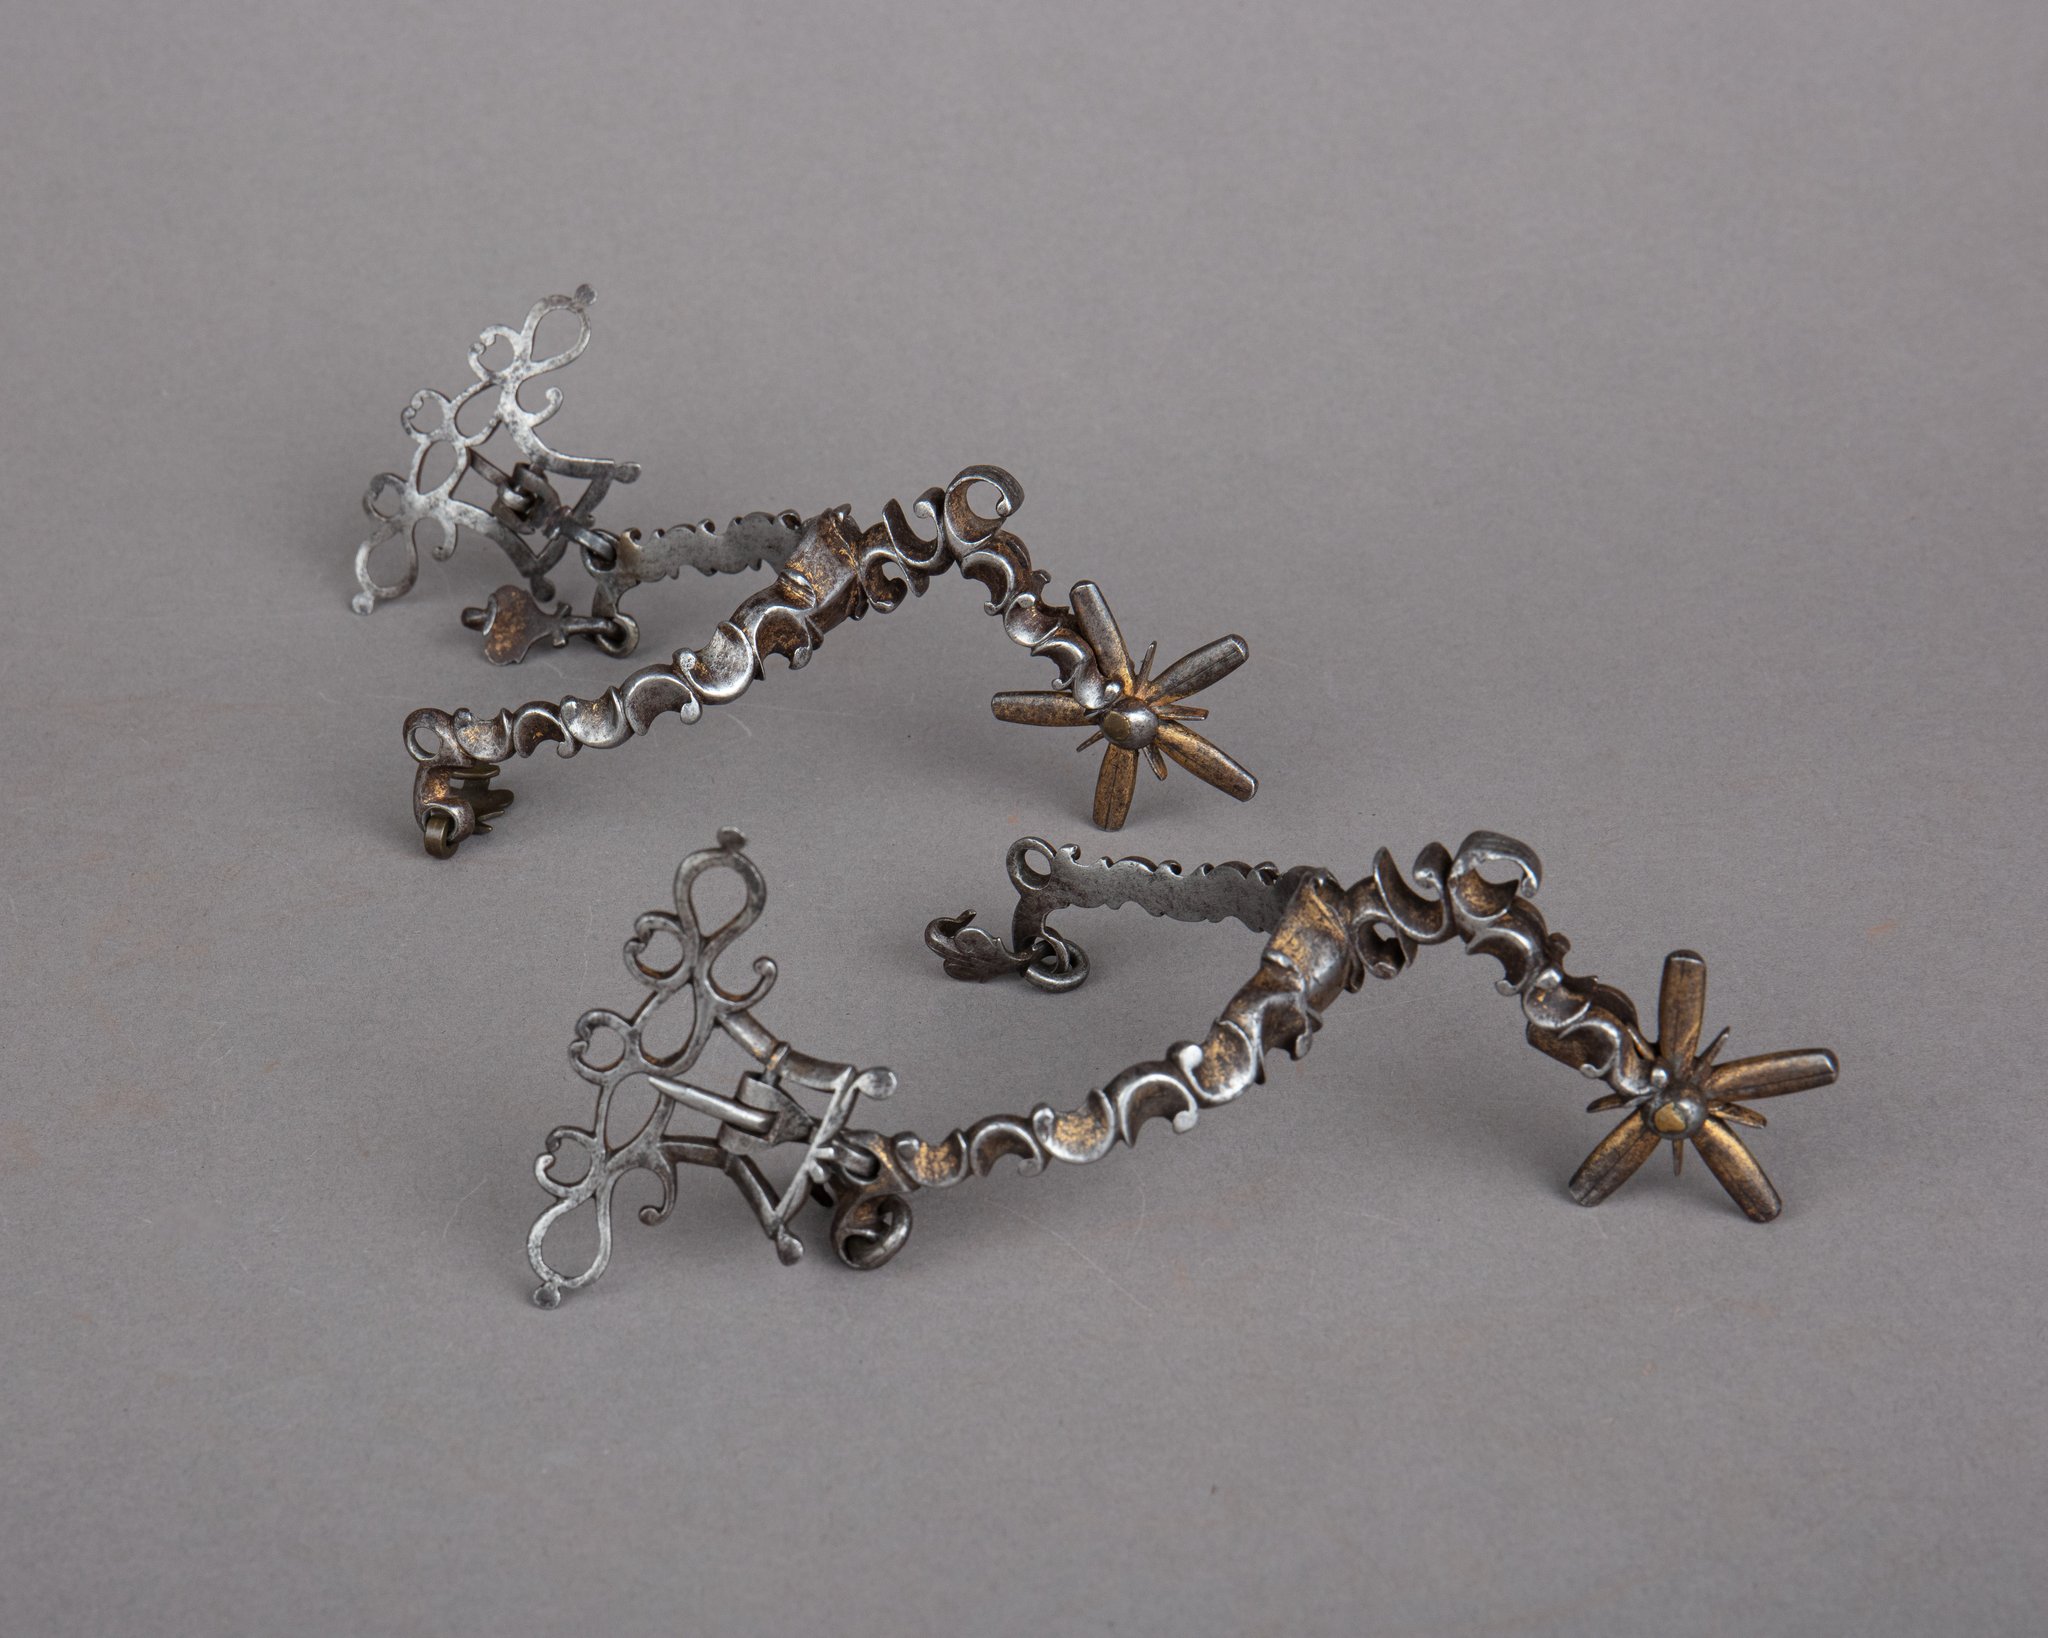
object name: spur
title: Pair of Rowel Spurs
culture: dutch or german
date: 1650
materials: copper alloy, metal alloy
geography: netherlands